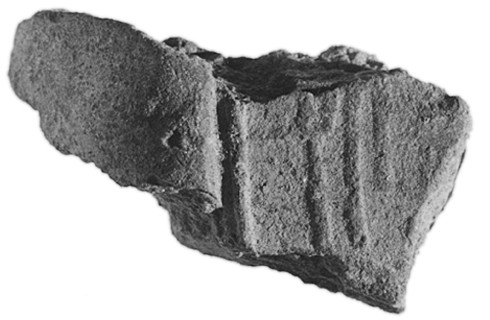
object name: sealing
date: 2030-1640 BCE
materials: clay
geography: egypt